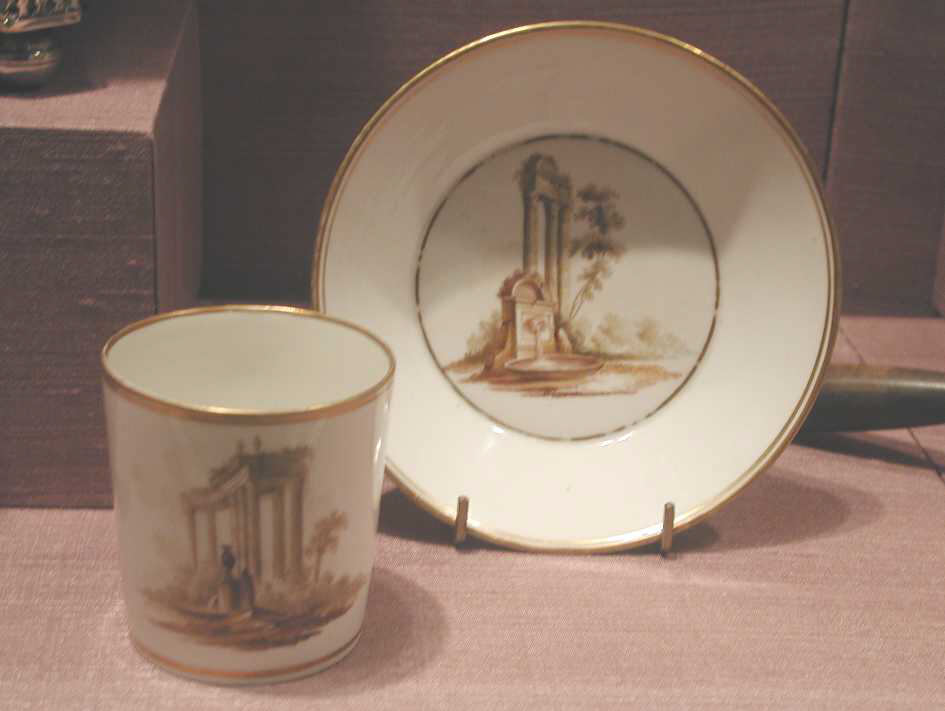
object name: cup and saucer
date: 1790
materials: hard paste porcelain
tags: columns,temples